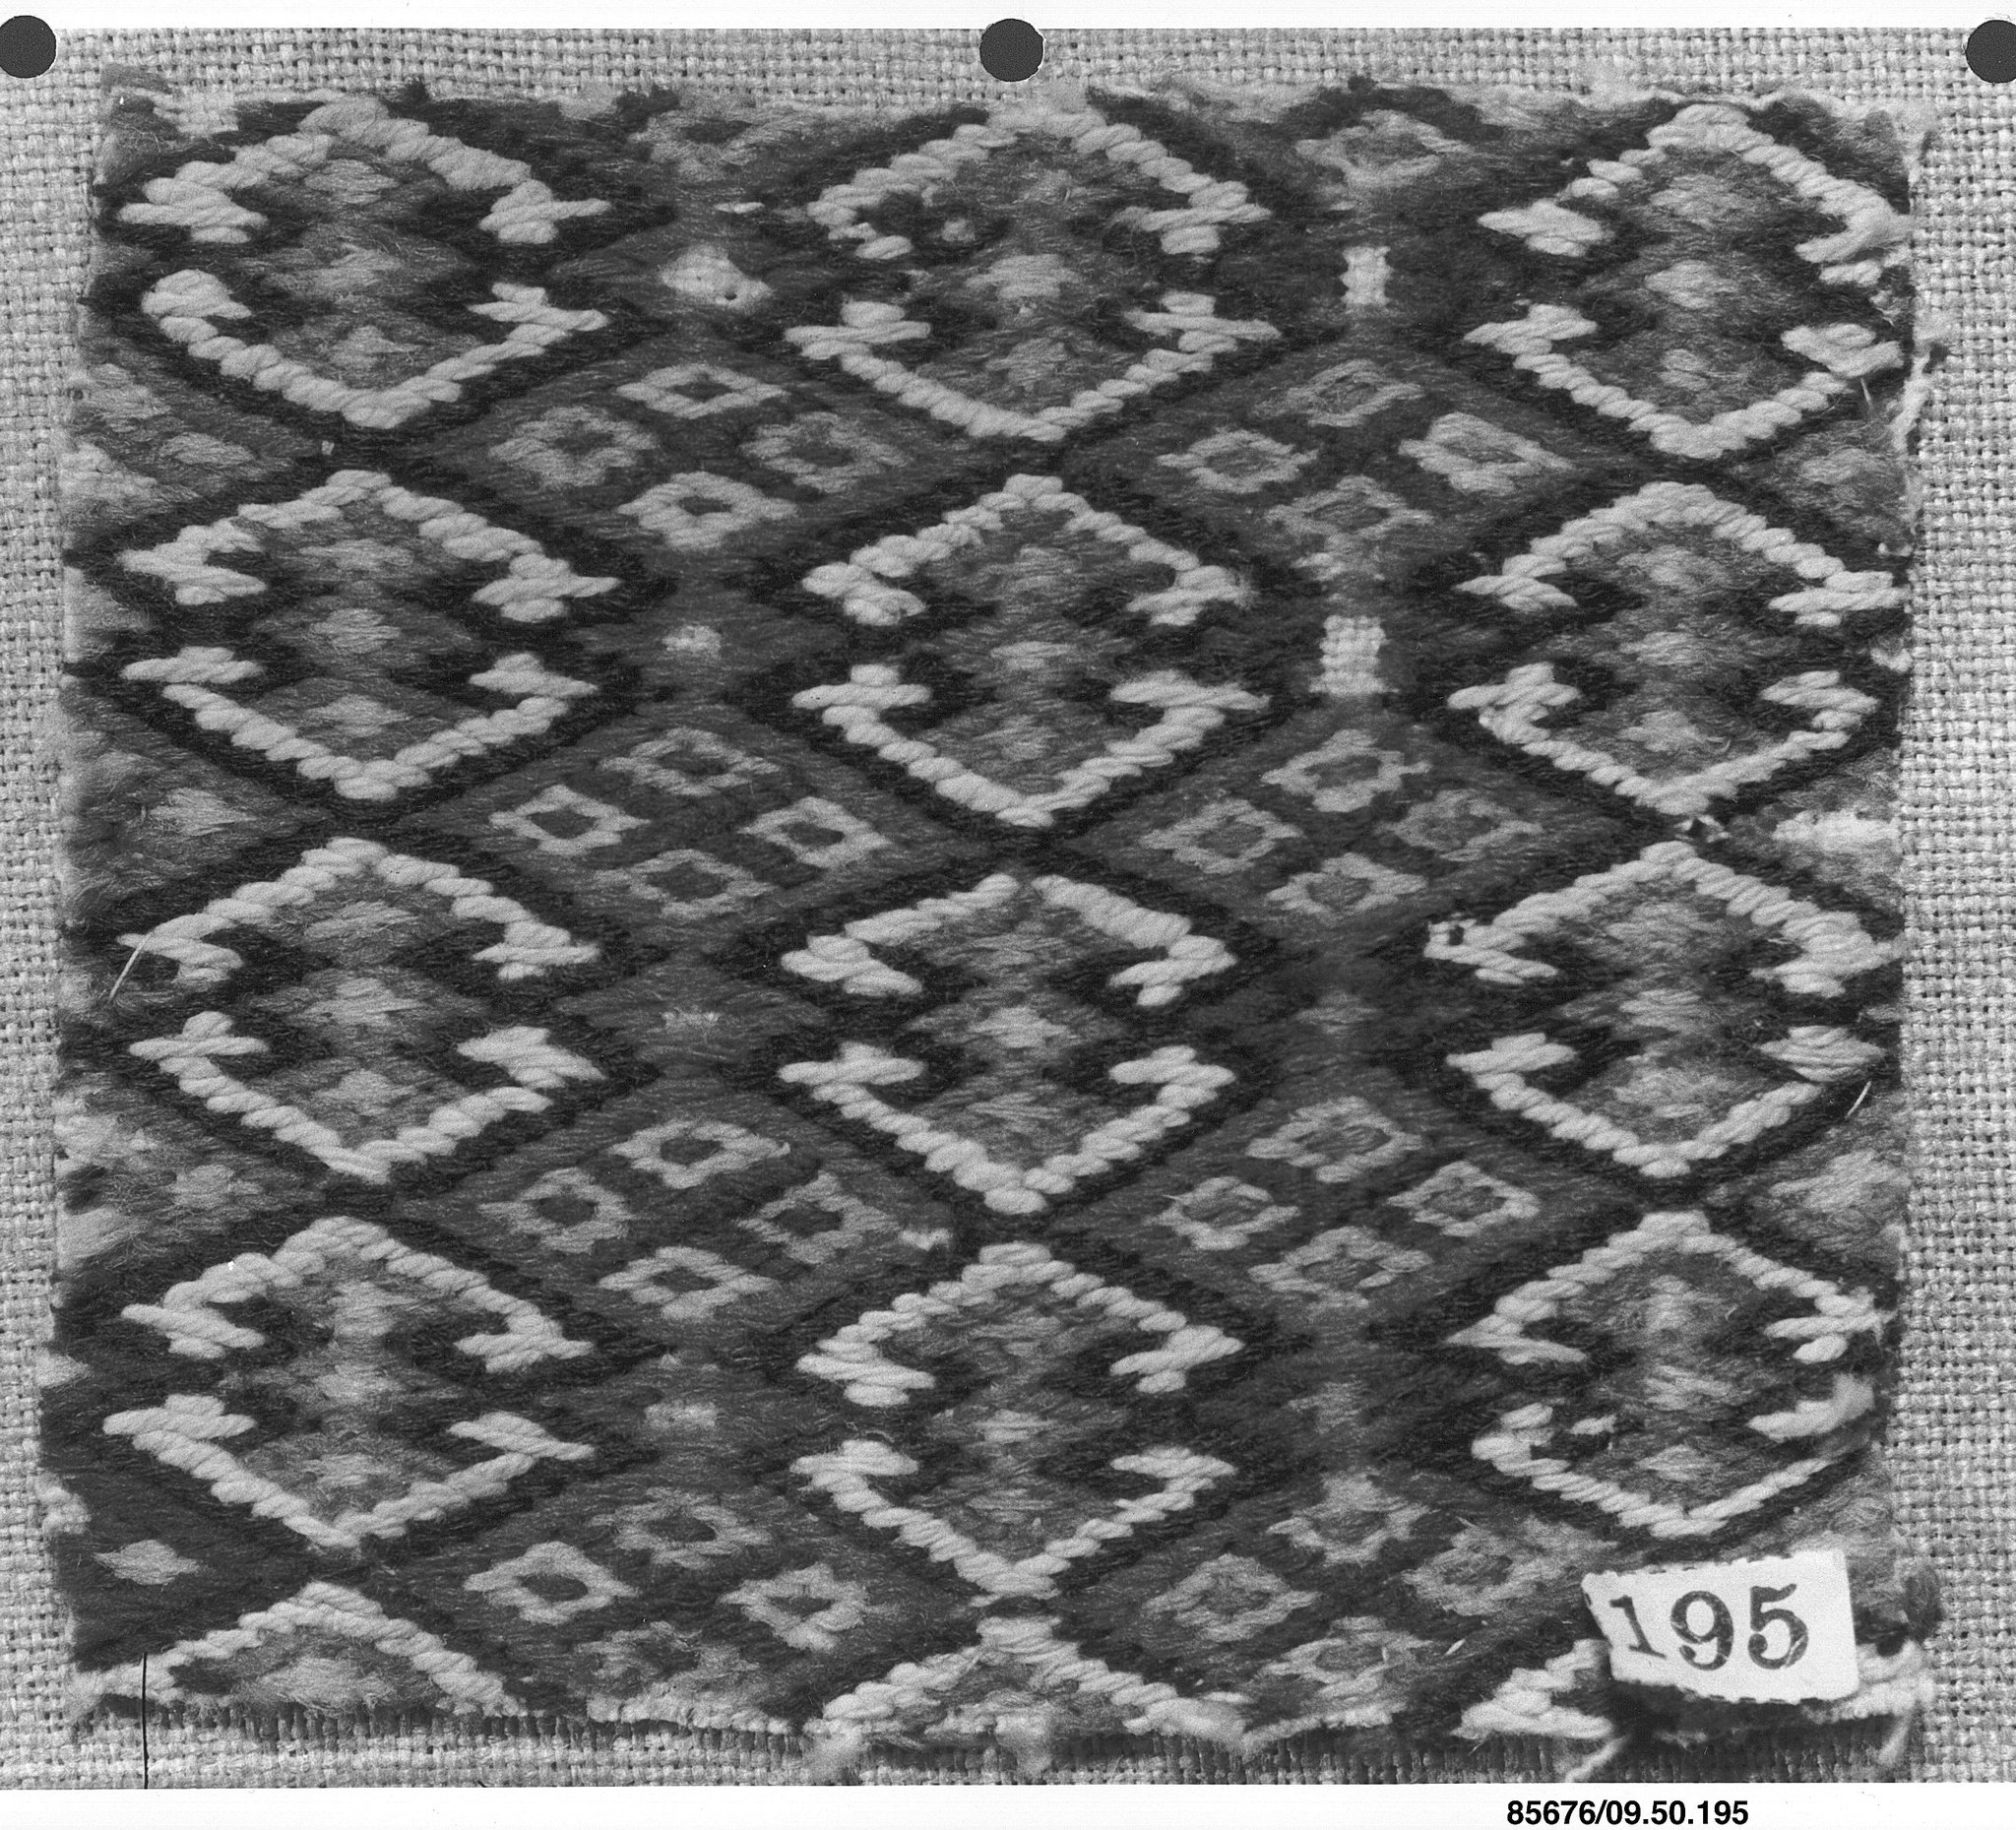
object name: costume fragment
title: Peasant costume fragment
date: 1701-1900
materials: canvas, wool